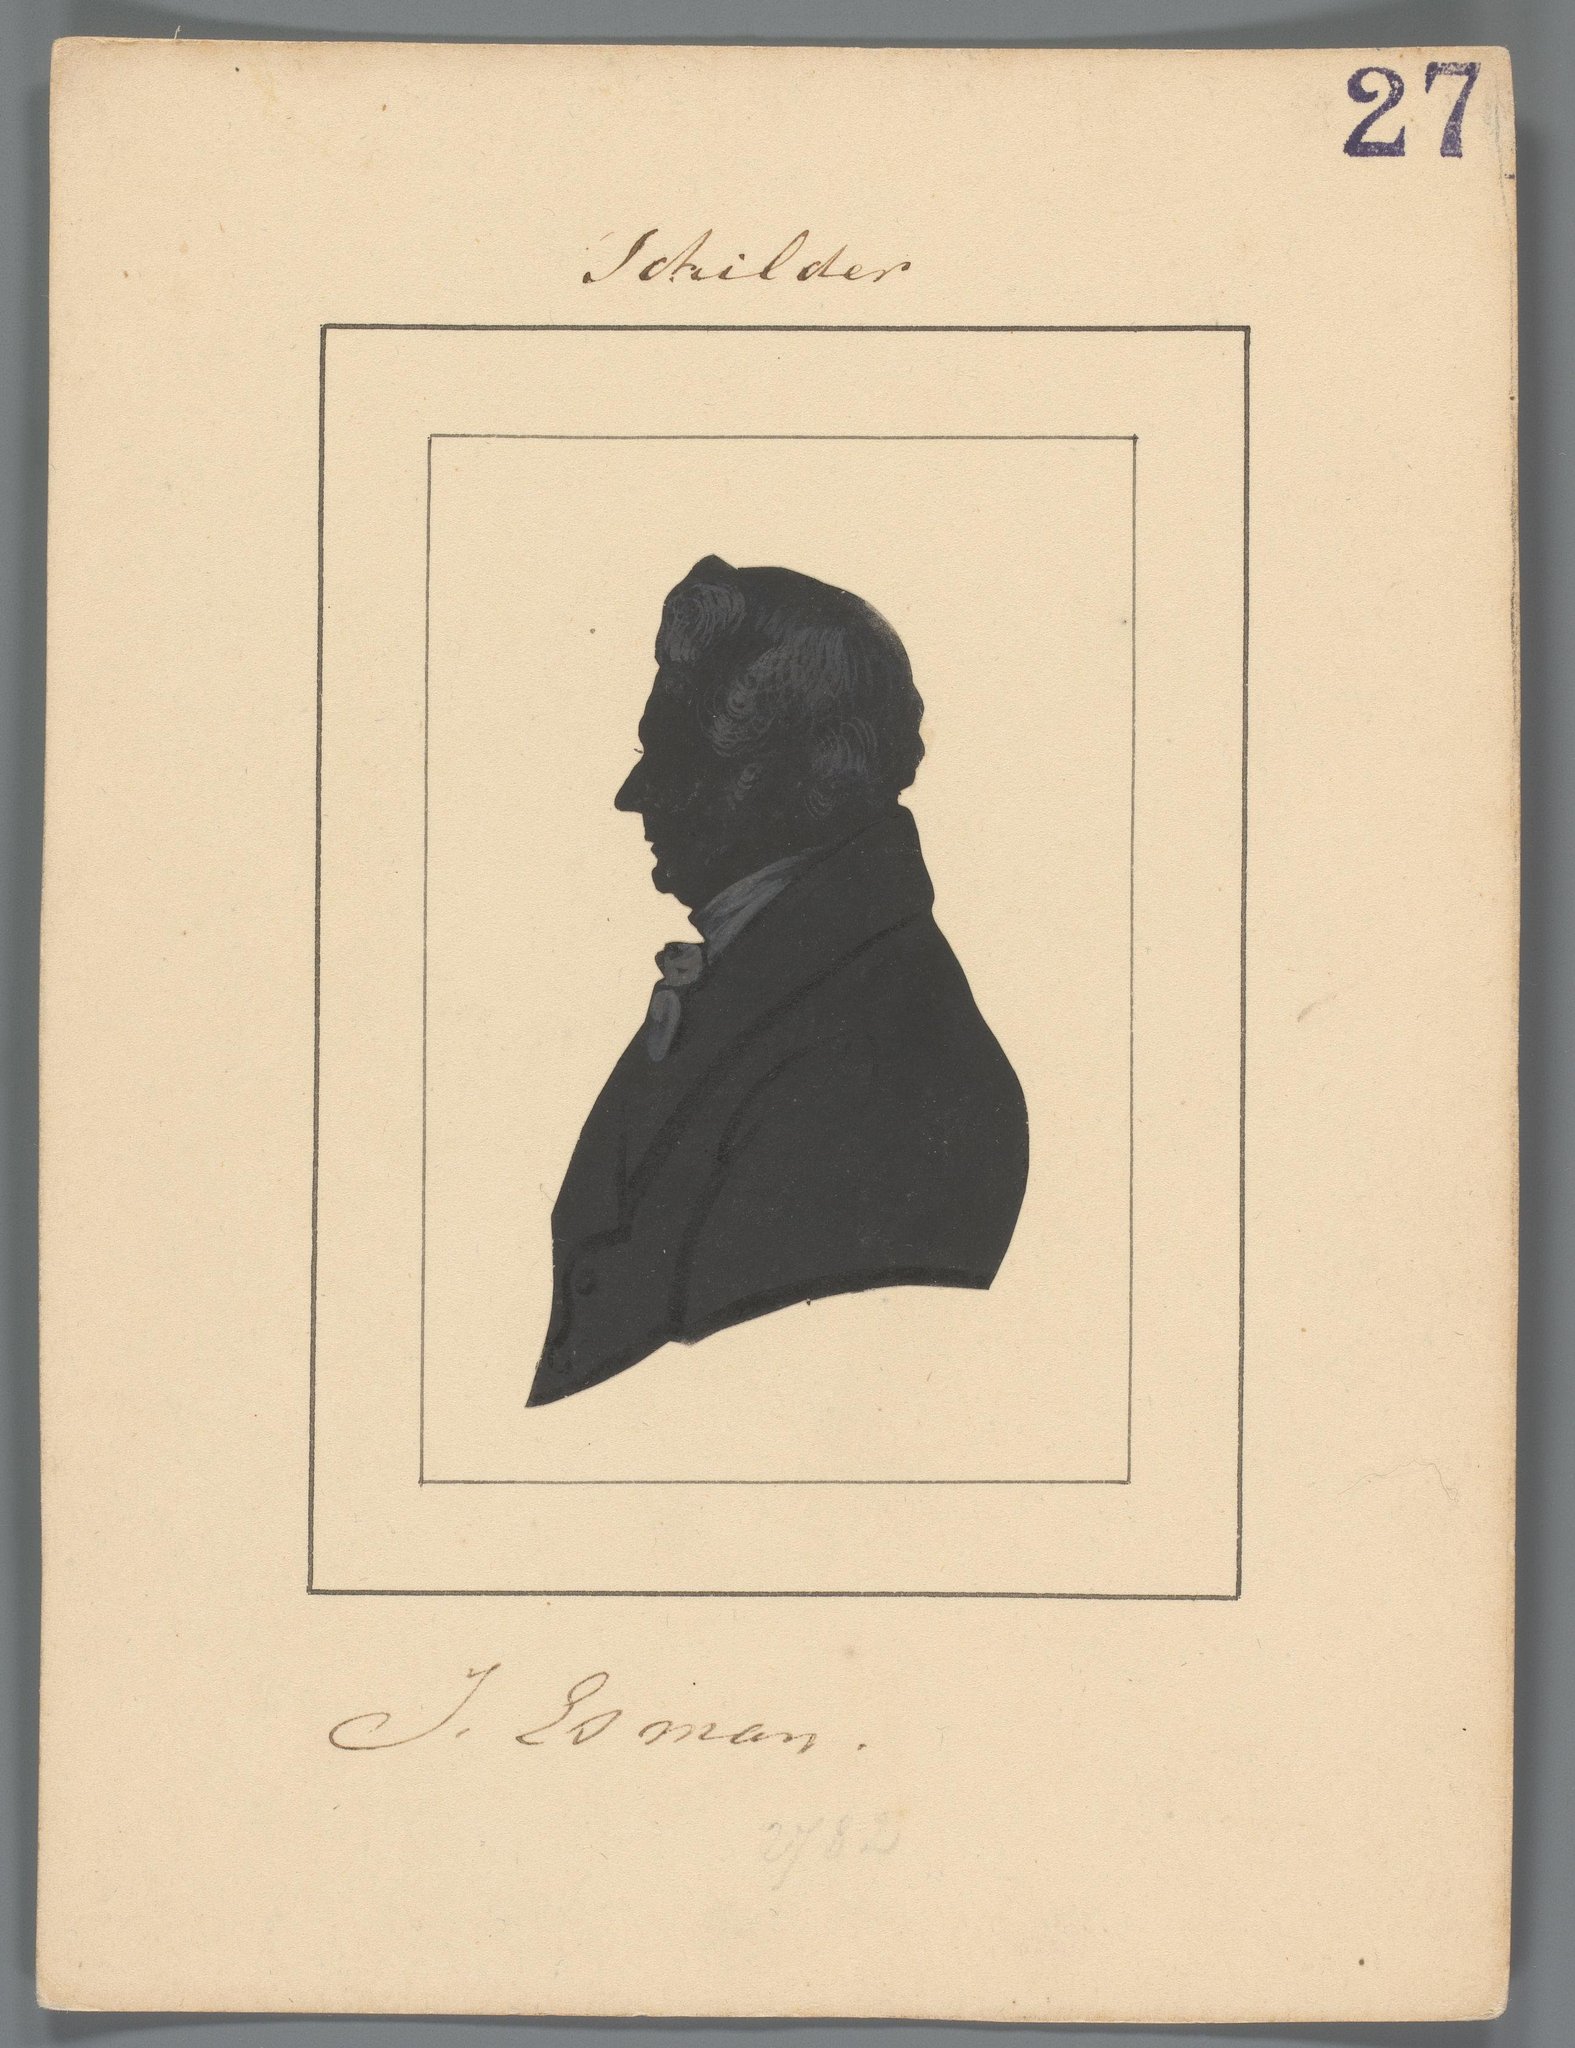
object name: silhouette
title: Silhouetportret van Joannes Esman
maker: elisabeth alida haanen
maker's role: draughtsman, print maker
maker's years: 1809-1845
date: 1819-1845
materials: ink, paint, paper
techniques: brush, snipping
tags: antwerp, joannes esman, historical persons, portrait, self-portrait of painter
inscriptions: collector's mark: ‘Ex-libris van Beresteyn’, number: ‘13946’, inscription: ‘Schilder’, inscription: ‘J. Esman.’, inscription: ‘Neg. D. 1759’, number: ‘27’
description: Met onder het portret de handtekening van de geportretteerde.